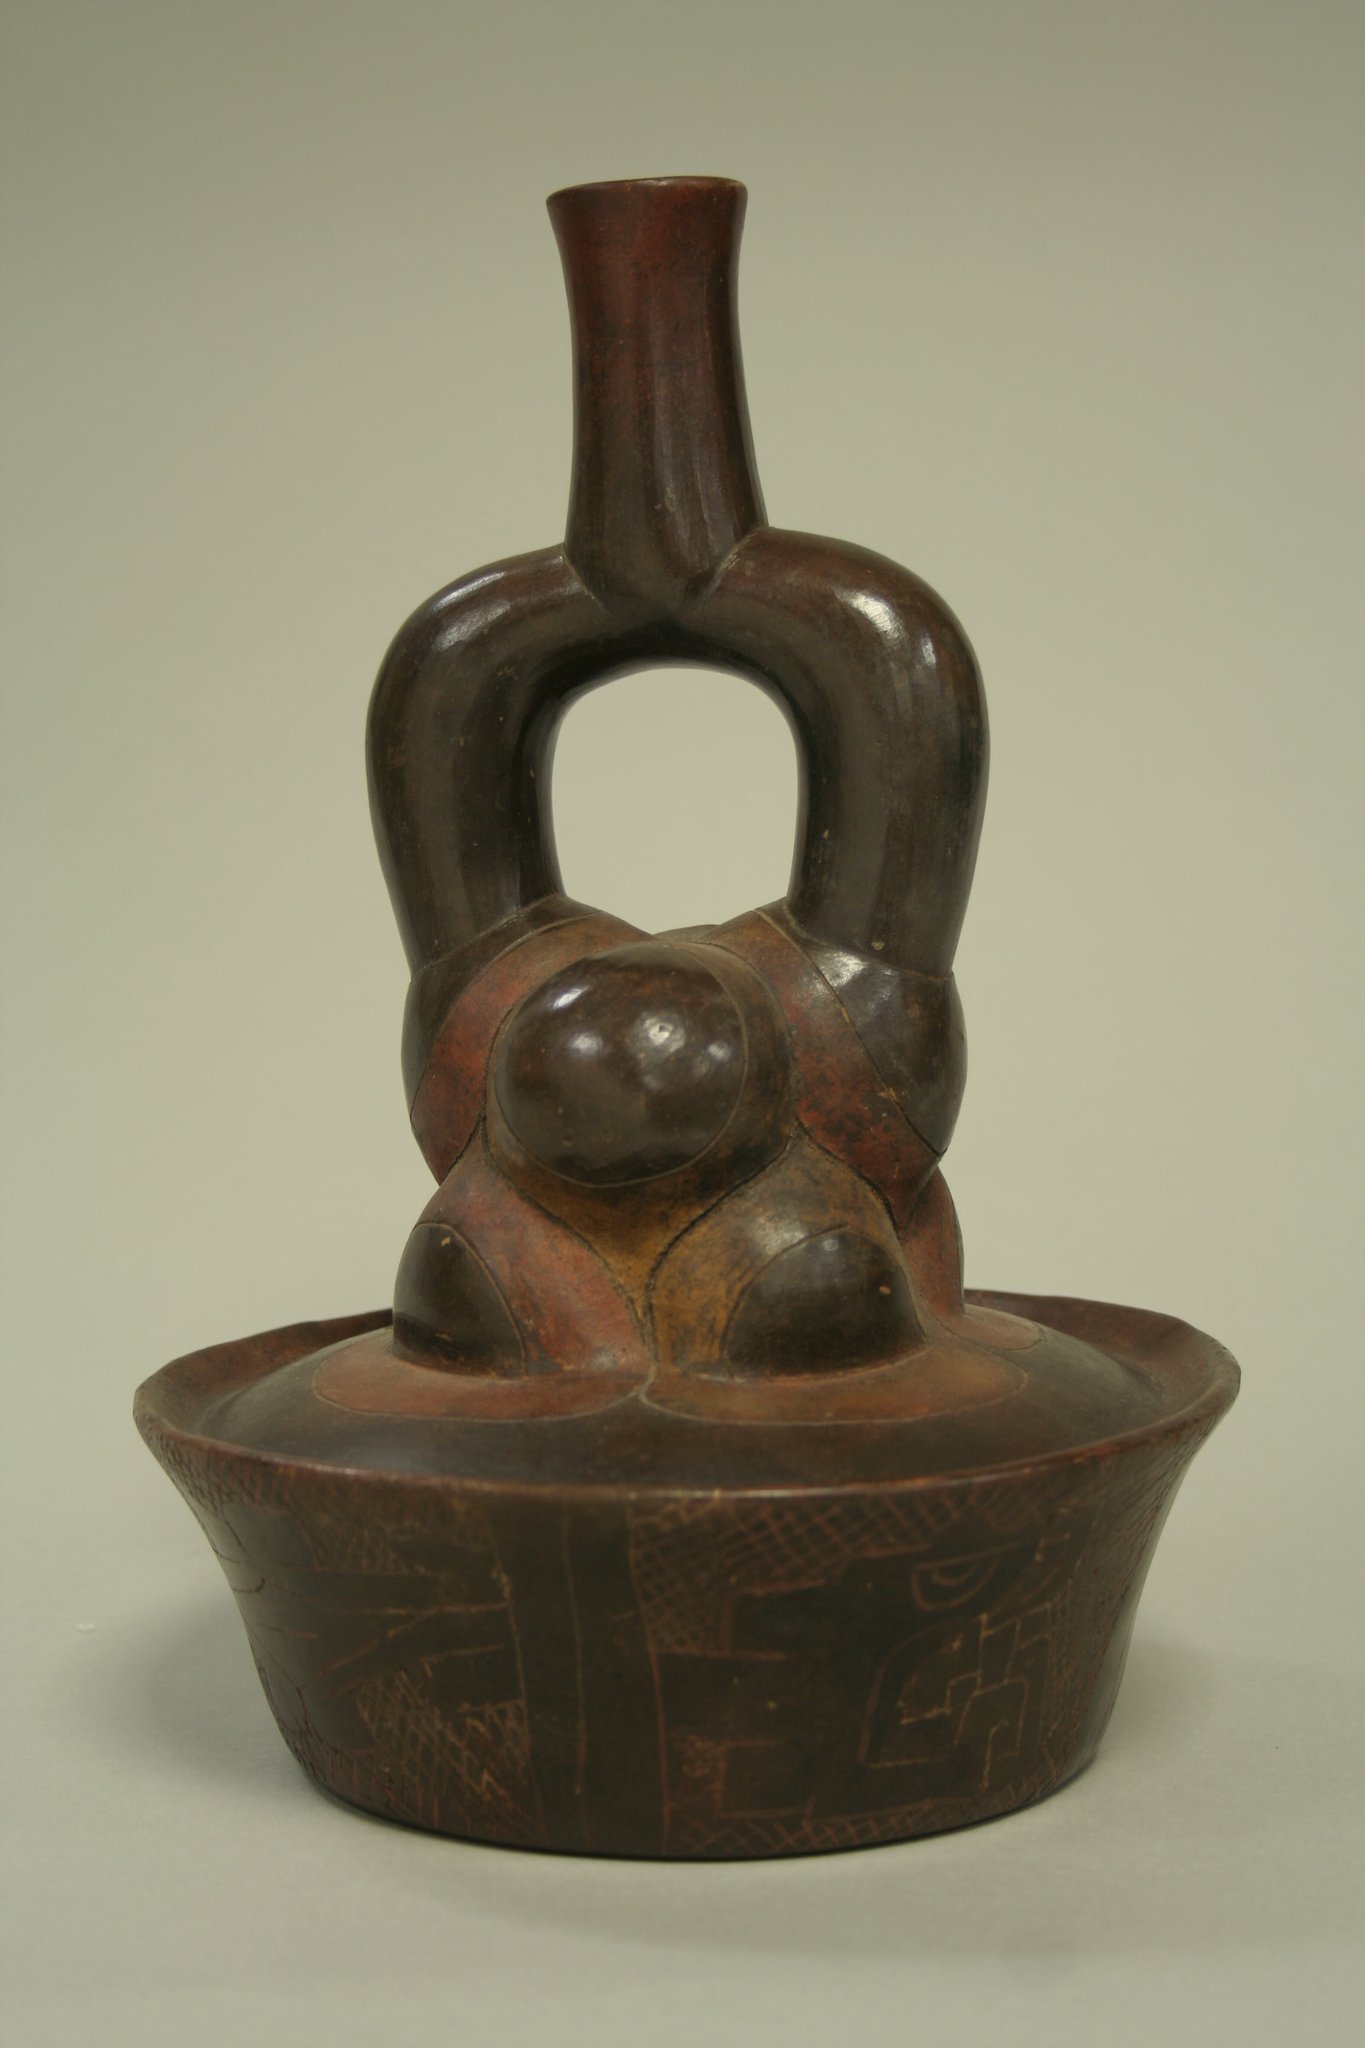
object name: bottle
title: Stirrup Spout Bottle: Fruit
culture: cupisnique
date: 1200-801 BCE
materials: ceramic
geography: peru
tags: fruit